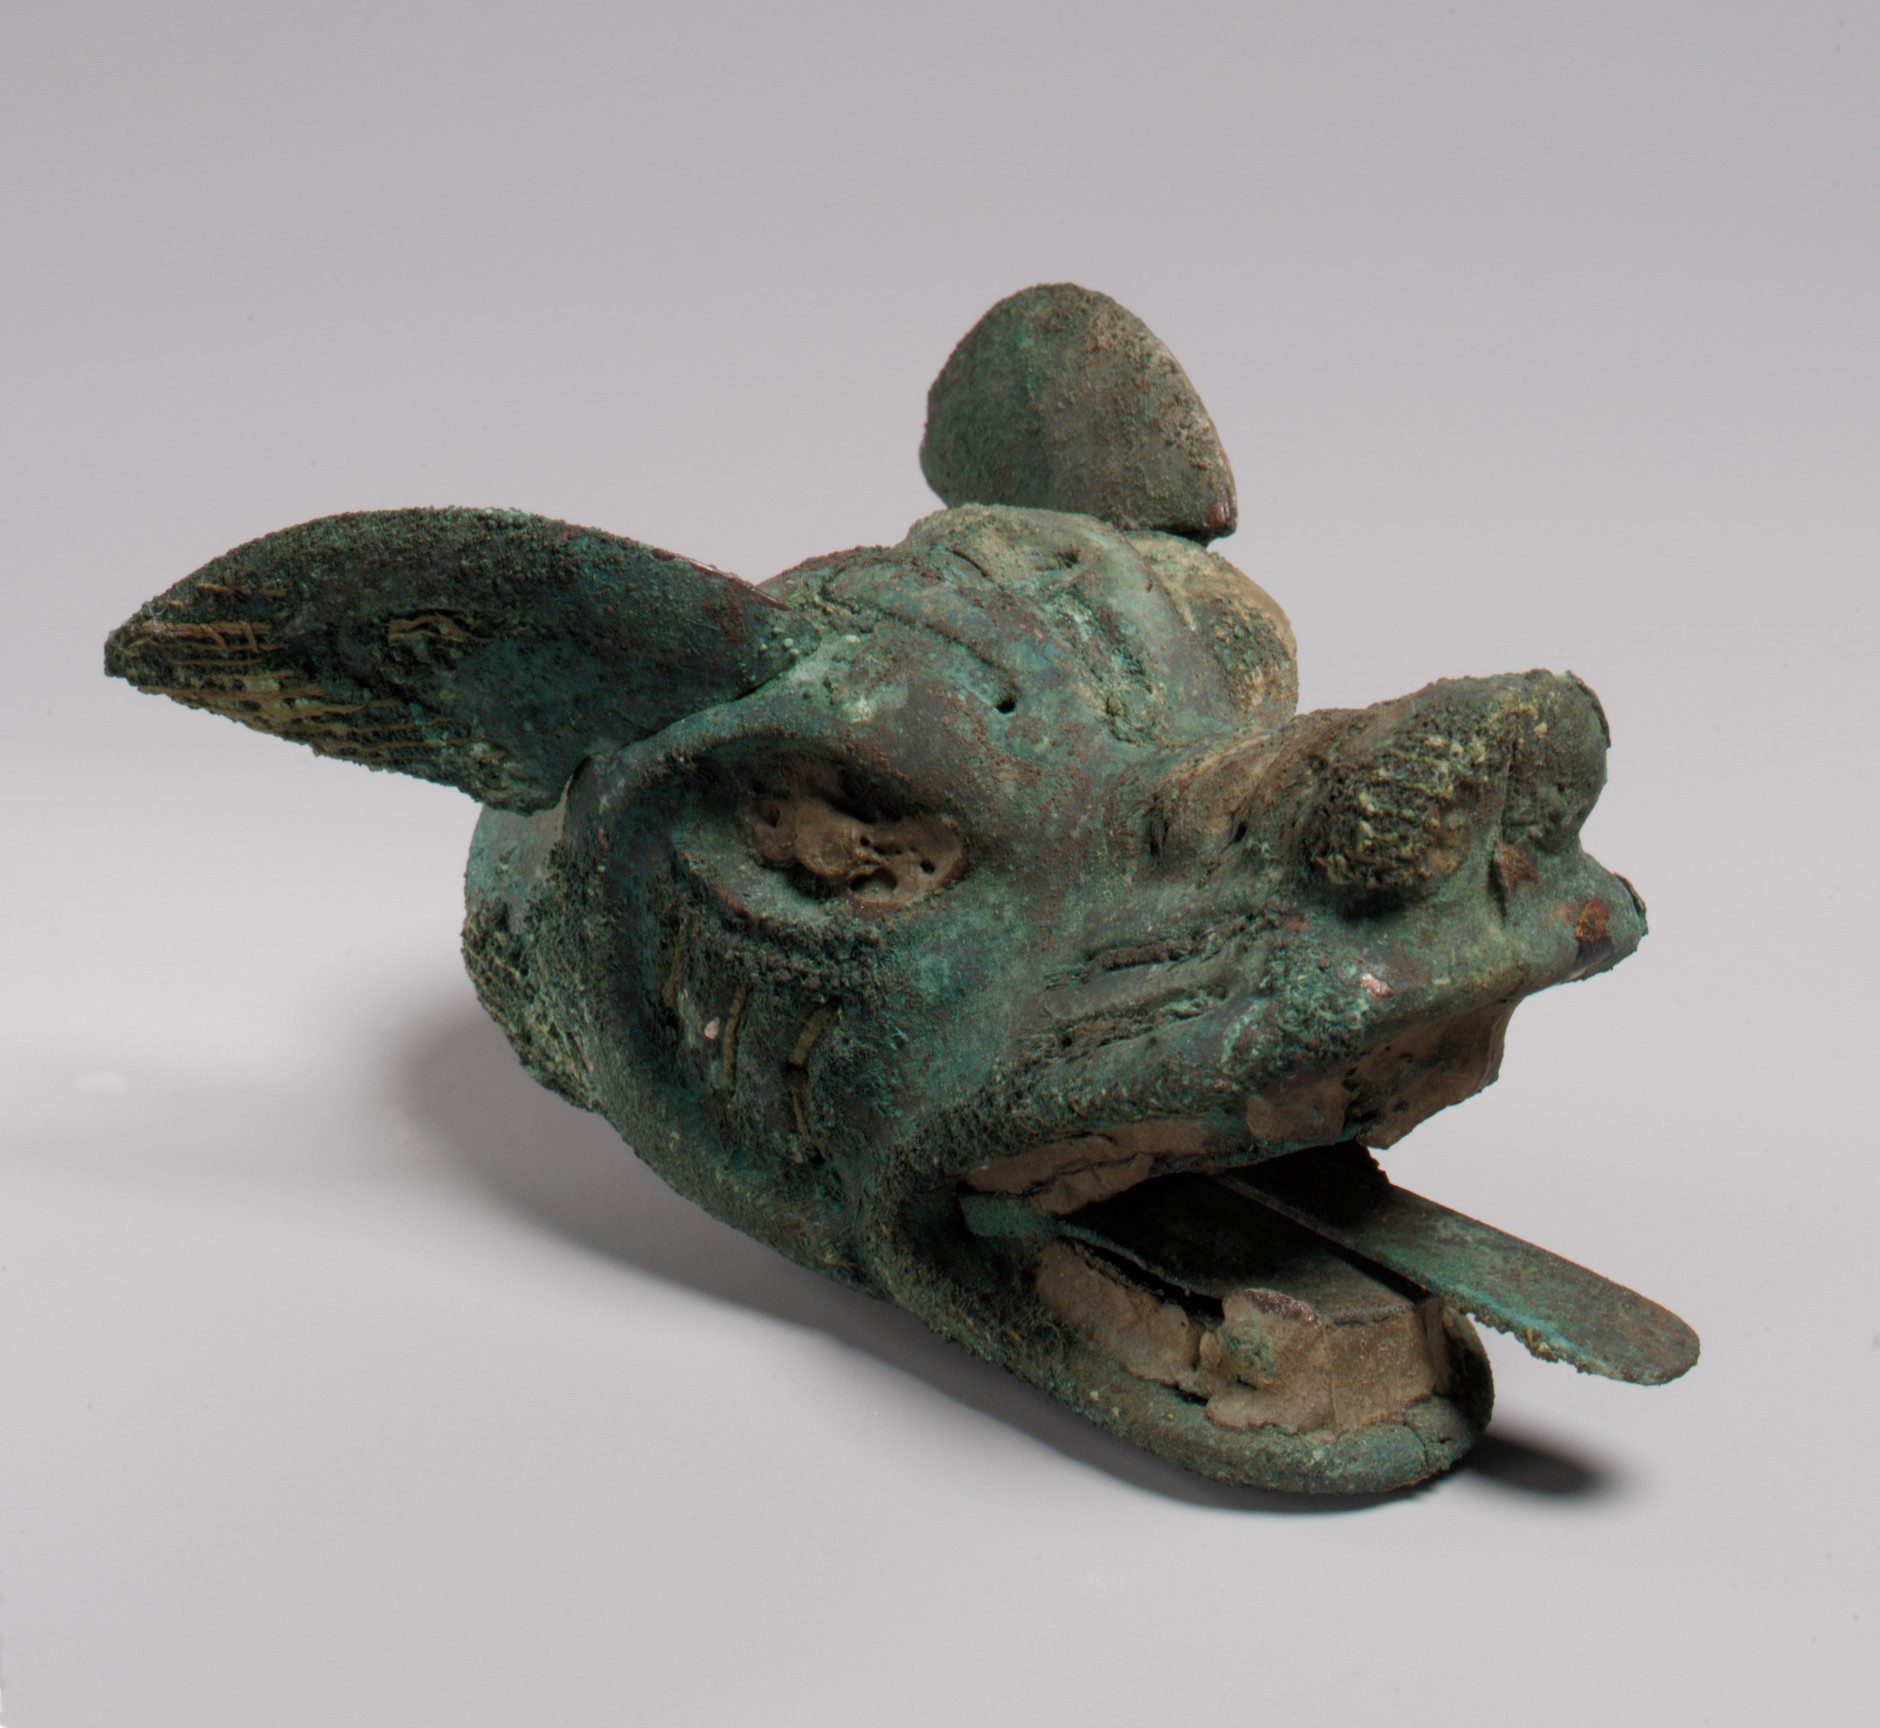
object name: ornament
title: Fox Head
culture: moche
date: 501-700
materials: gilt copper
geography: peru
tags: foxes